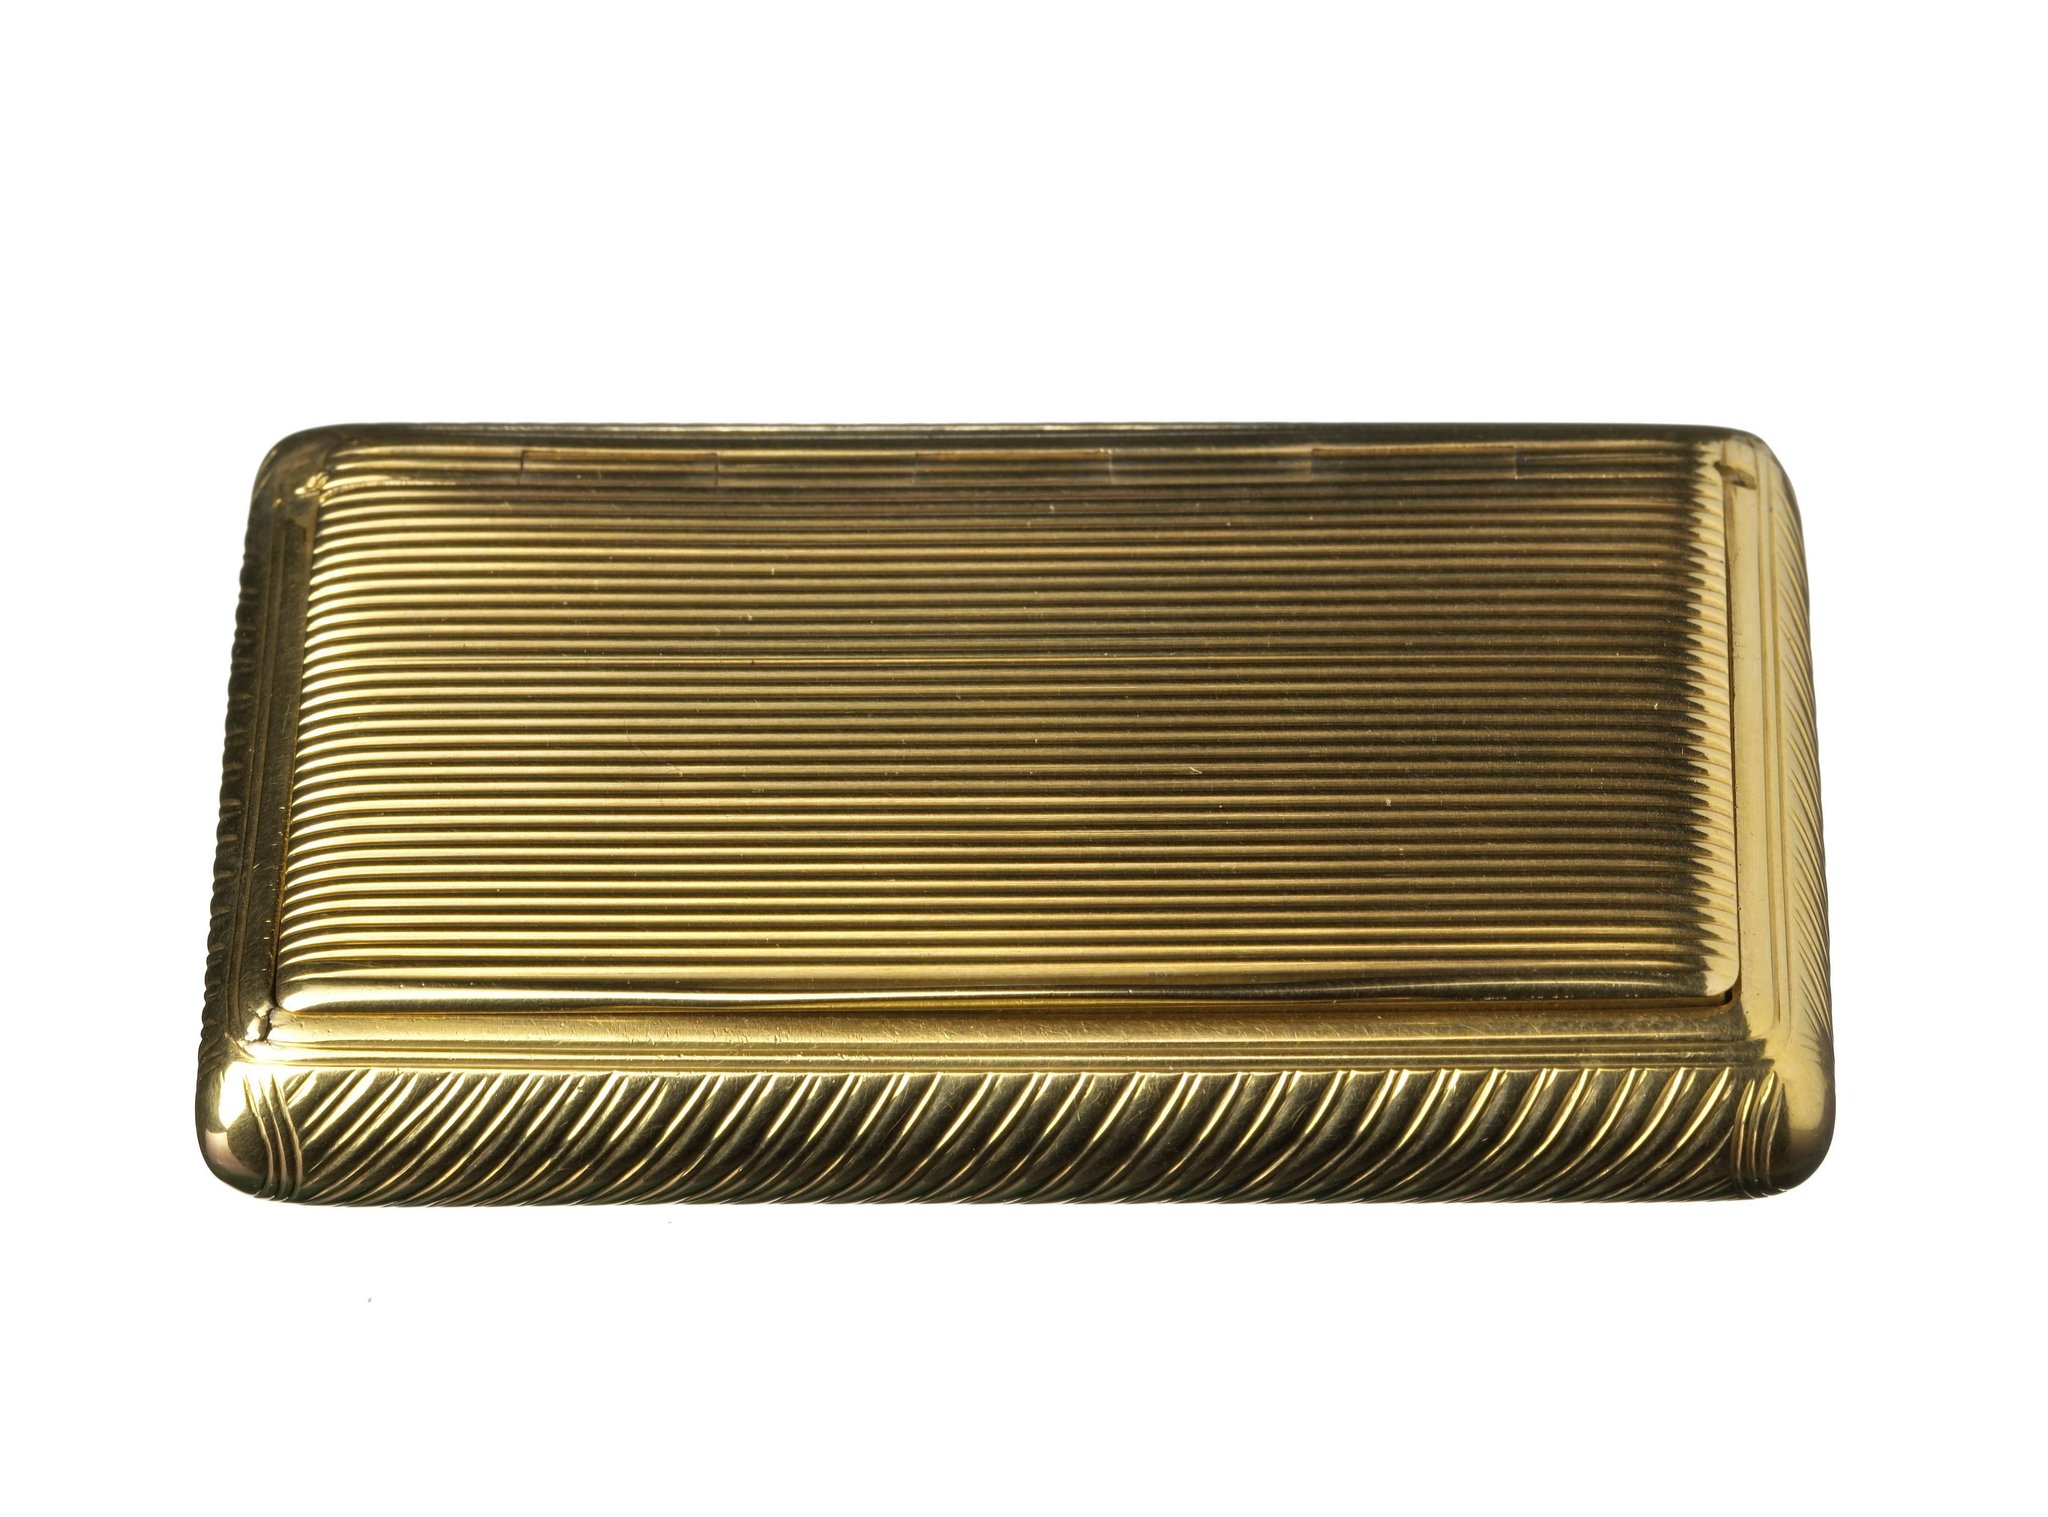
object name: snuffbox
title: Snuifdoos, rechthoekig, met een bolle wand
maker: barend enzering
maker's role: goldsmith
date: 1825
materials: gold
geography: amsterdam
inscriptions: maker's mark, date letter: ‘Q’, alloy mark, town mark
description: De rechthoekige, platte doos heeft bolle wanden met afgeronde hoeken en een scharnierend deksel met een iets opstaand, gebogen lipje. De onderzijde en het deksel zijn versierd met een patroon van liggende ribbels; de zijden met een patroon van diagonale, afwisselend smalle en bredere ribbels. De boven- en onderrrand zijn onversierd gelaten, evenals de hoeken, die aan weerszijden afgekaderd zijn door twee gebogen ribbels.